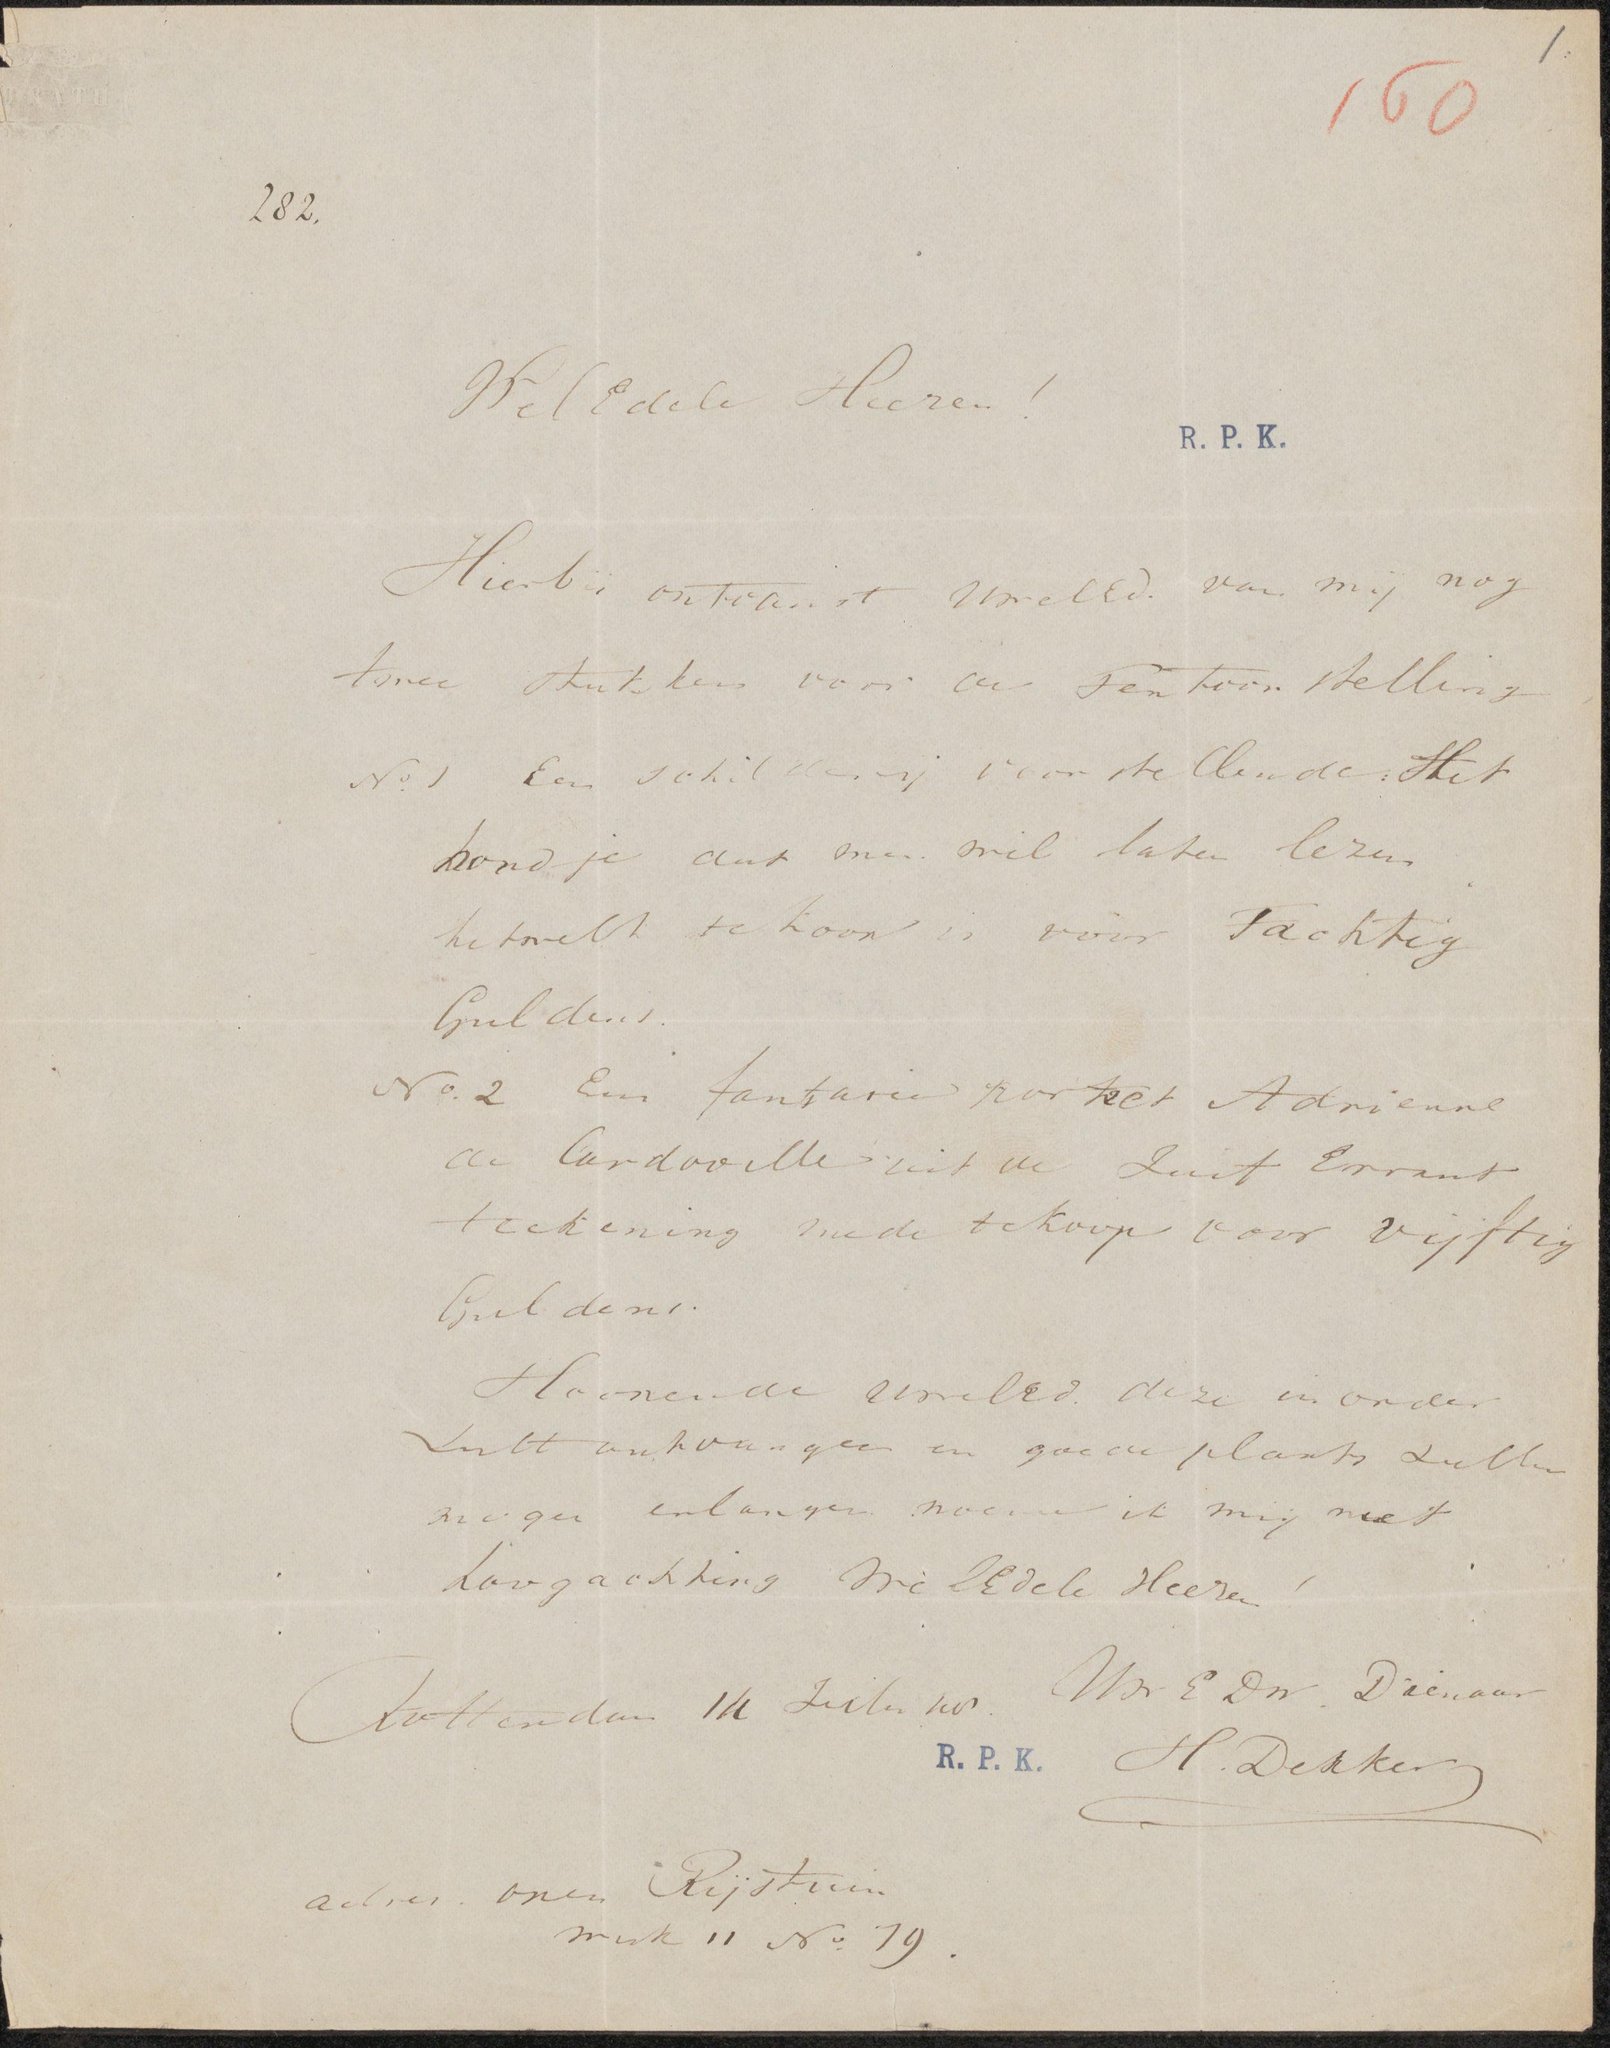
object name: letter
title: Brief aan anoniem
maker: hendrik dekker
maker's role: draughtsman, painter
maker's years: 1817-1889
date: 1848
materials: ink, paper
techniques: pen, writing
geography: rotterdam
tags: drawing, painting (including book-illumination, miniature-painting), exhibition ~ art, money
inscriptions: collector's mark: Lugt 2233